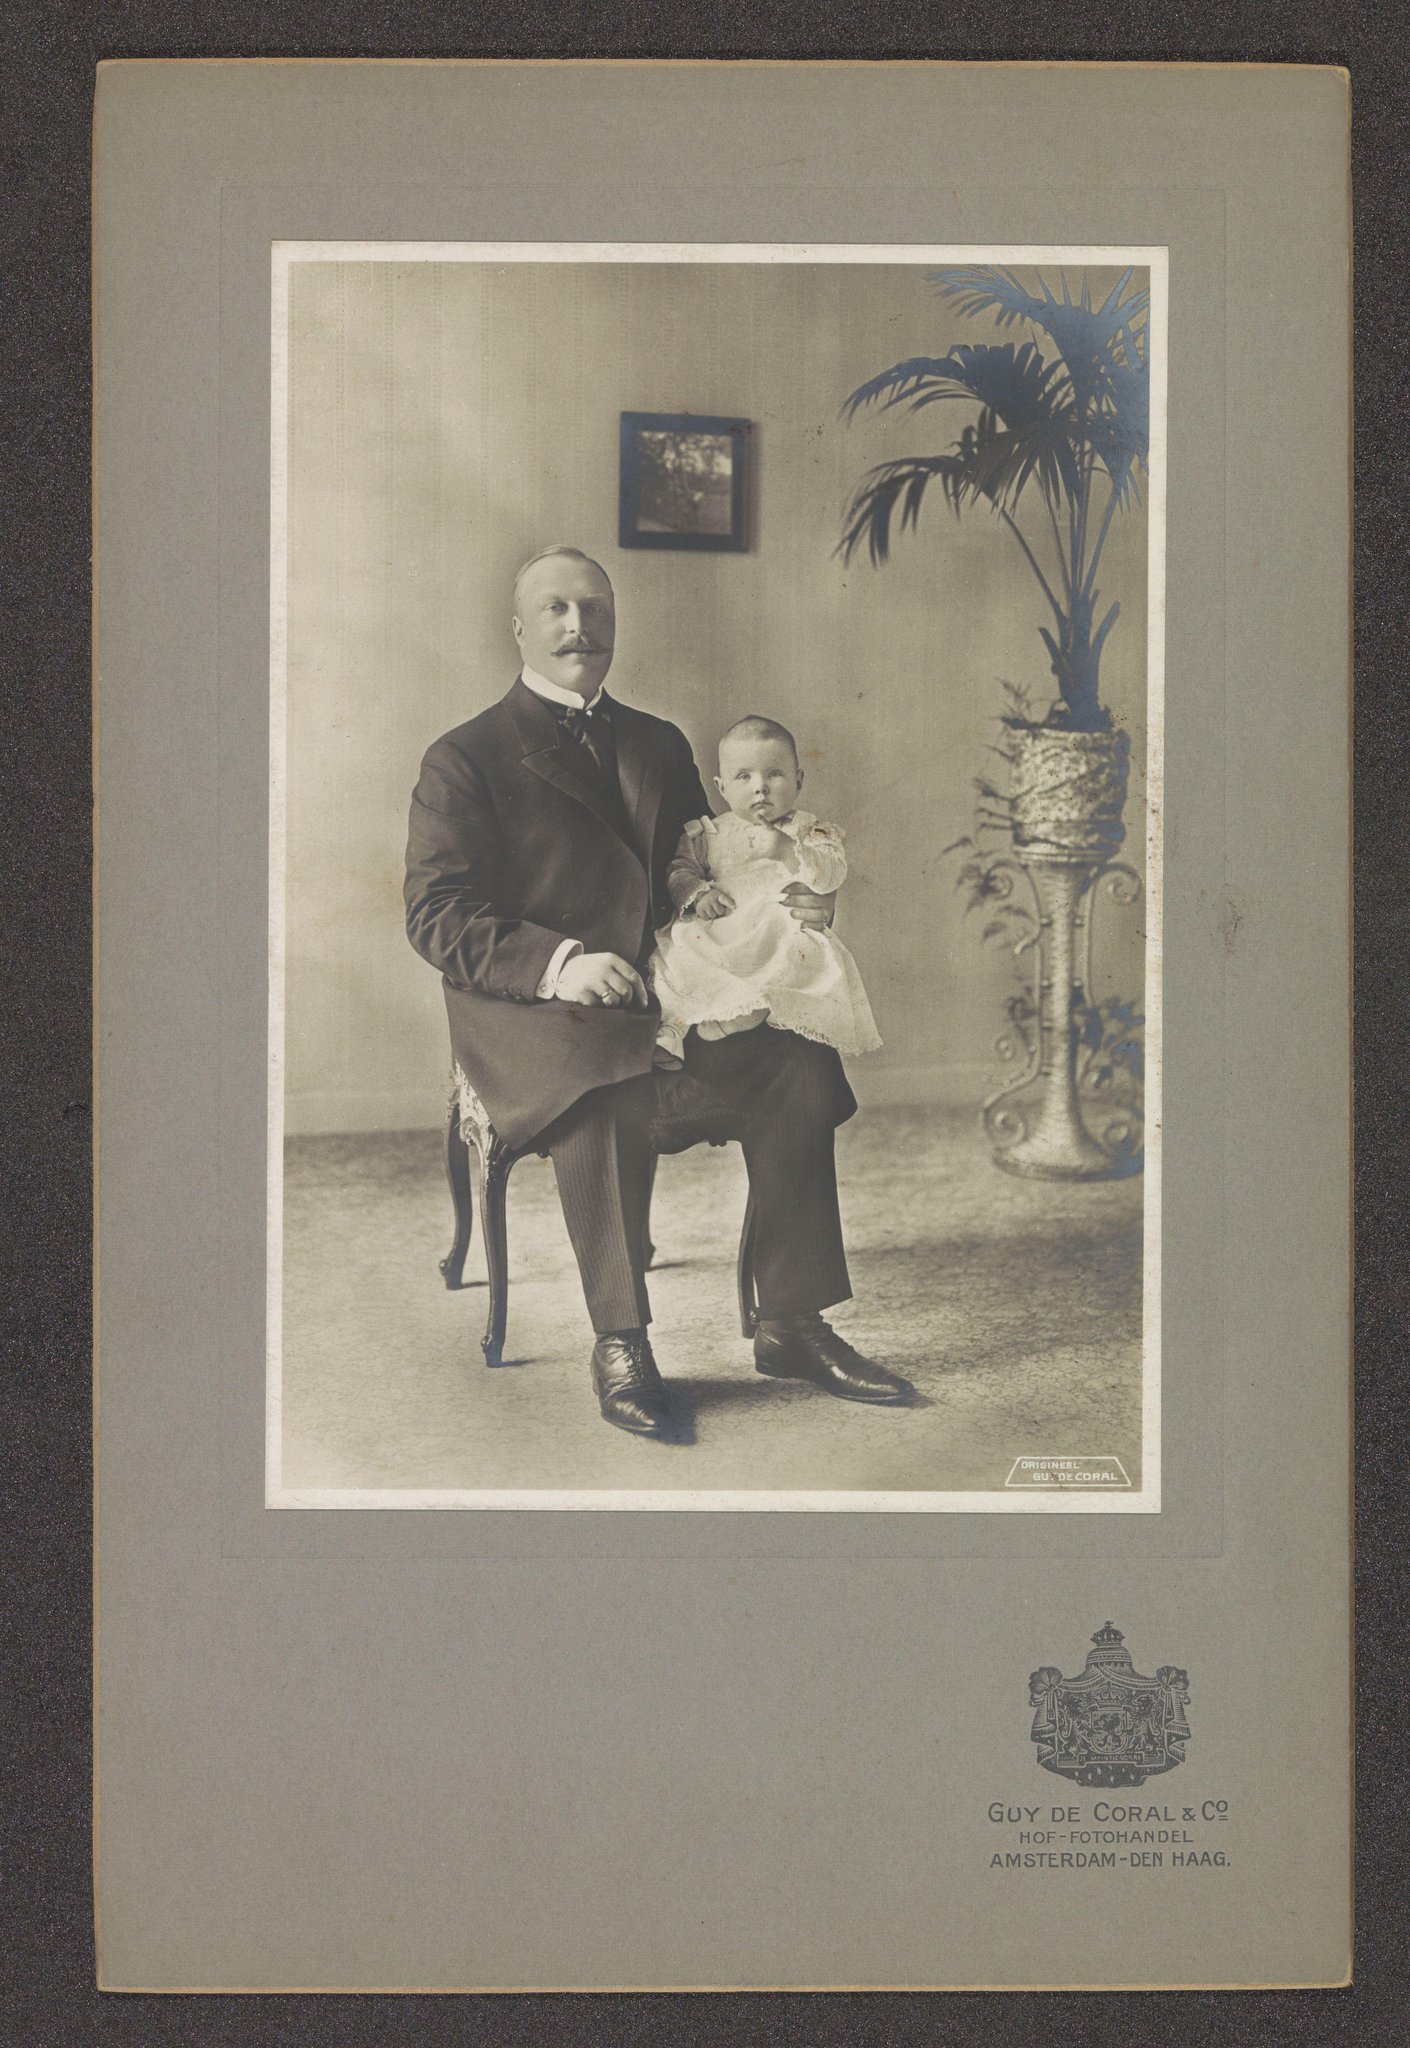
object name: photograph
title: Prins Hendrik met op schoot prinses Juliana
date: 1911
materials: cardboard, photographic support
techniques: photograph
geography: amsterdam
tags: the hague, hendrik (prins der nederlanden (1876-1934)), juliana of the netherlands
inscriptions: annotation: ‘Origineel Guy de Coral’, stamp: ‘uitg. Guy de Coral & Co., Hof.Fotohandel Amsterdam - Den Haag’